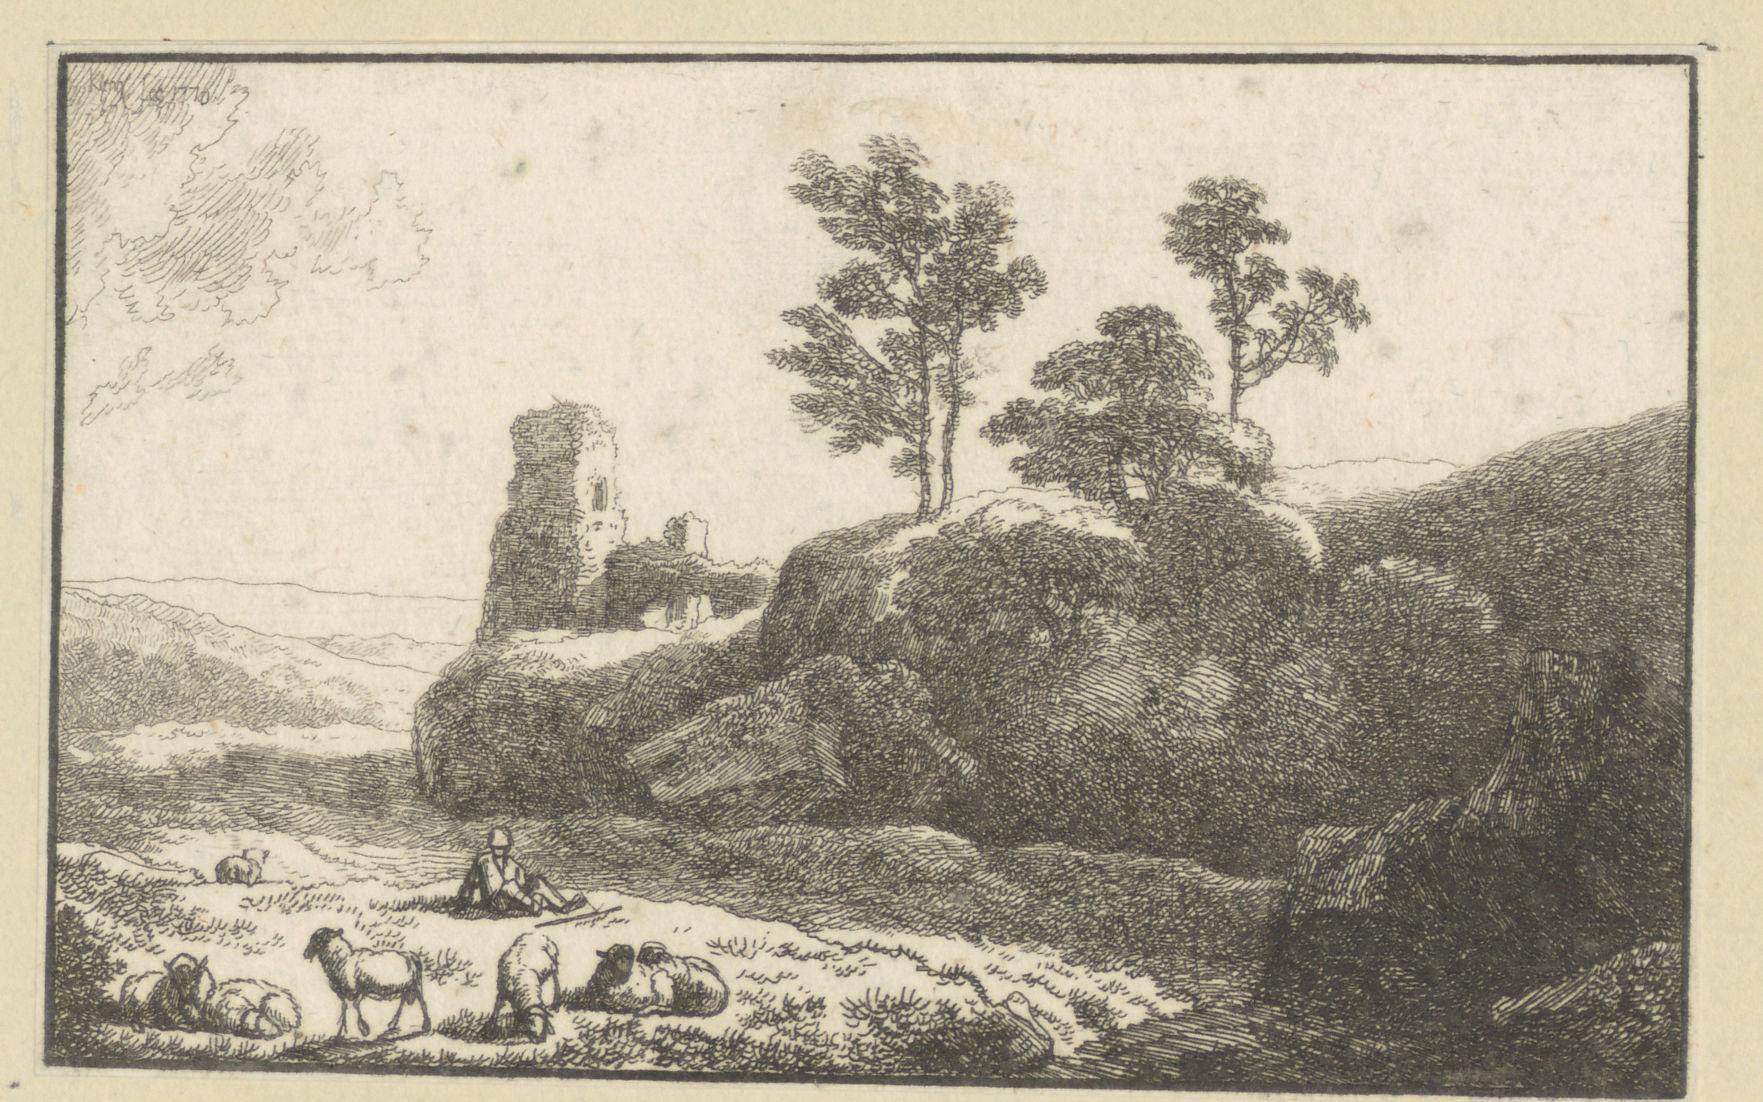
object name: print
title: Landschap met ruïne en herder met kudde schapen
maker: johann christian klengel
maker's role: print maker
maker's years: 1751-1824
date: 1770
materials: paper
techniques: etching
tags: herding, herdsman, herdswoman, shepherd, shepherdess, cowherd, etc., landscape with ruins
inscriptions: collector's mark: Lugt 240